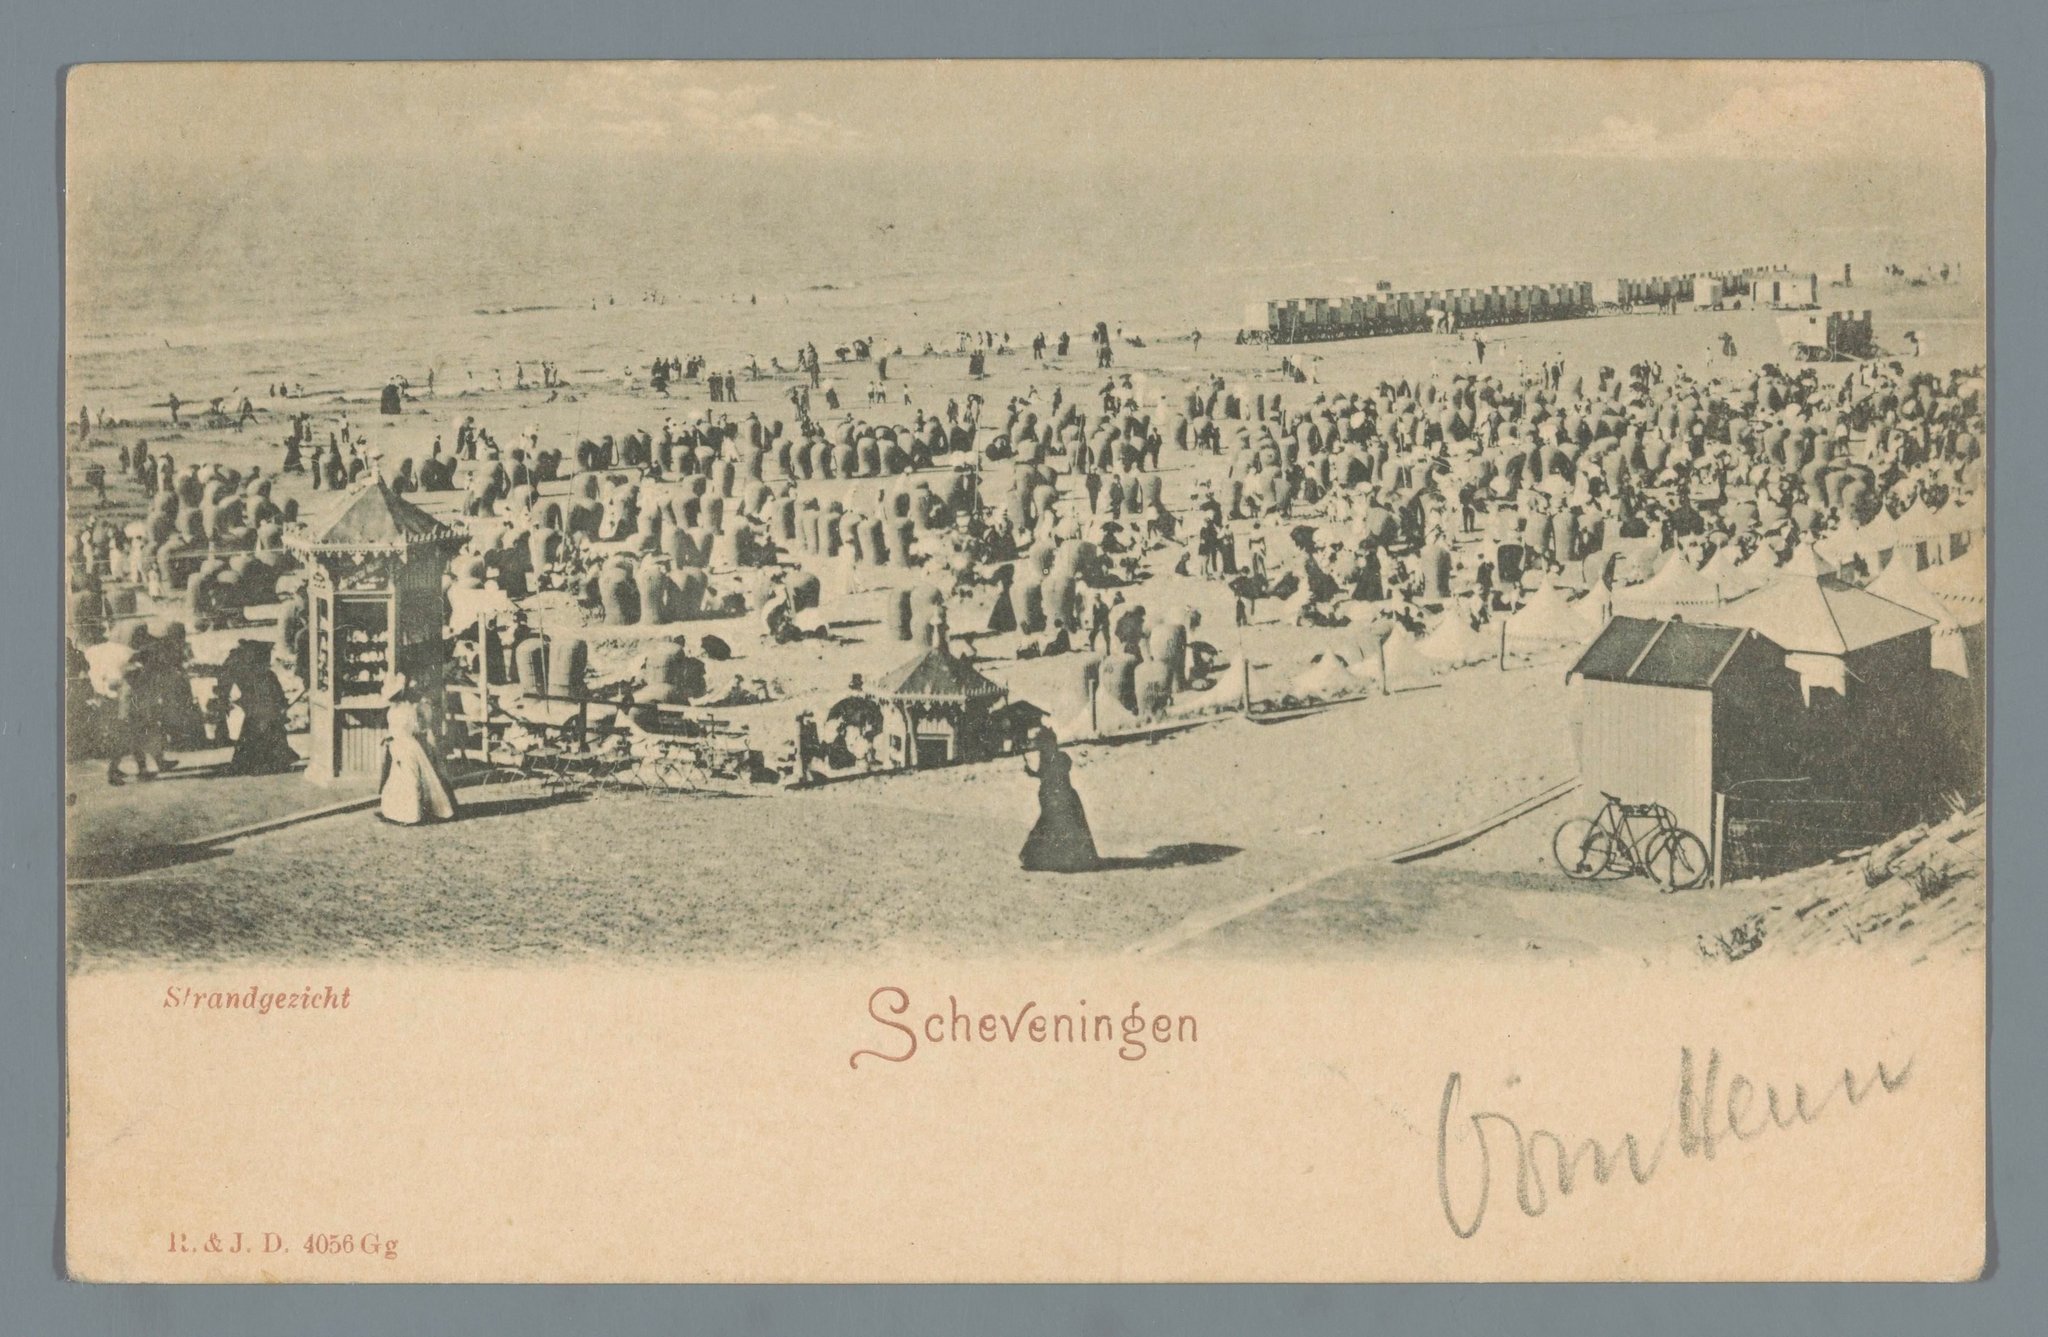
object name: photograph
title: Strandgezicht, Scheveningen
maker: Anonymous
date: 1890-1920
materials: cardboard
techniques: photograph, writing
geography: scheveningen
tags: beach